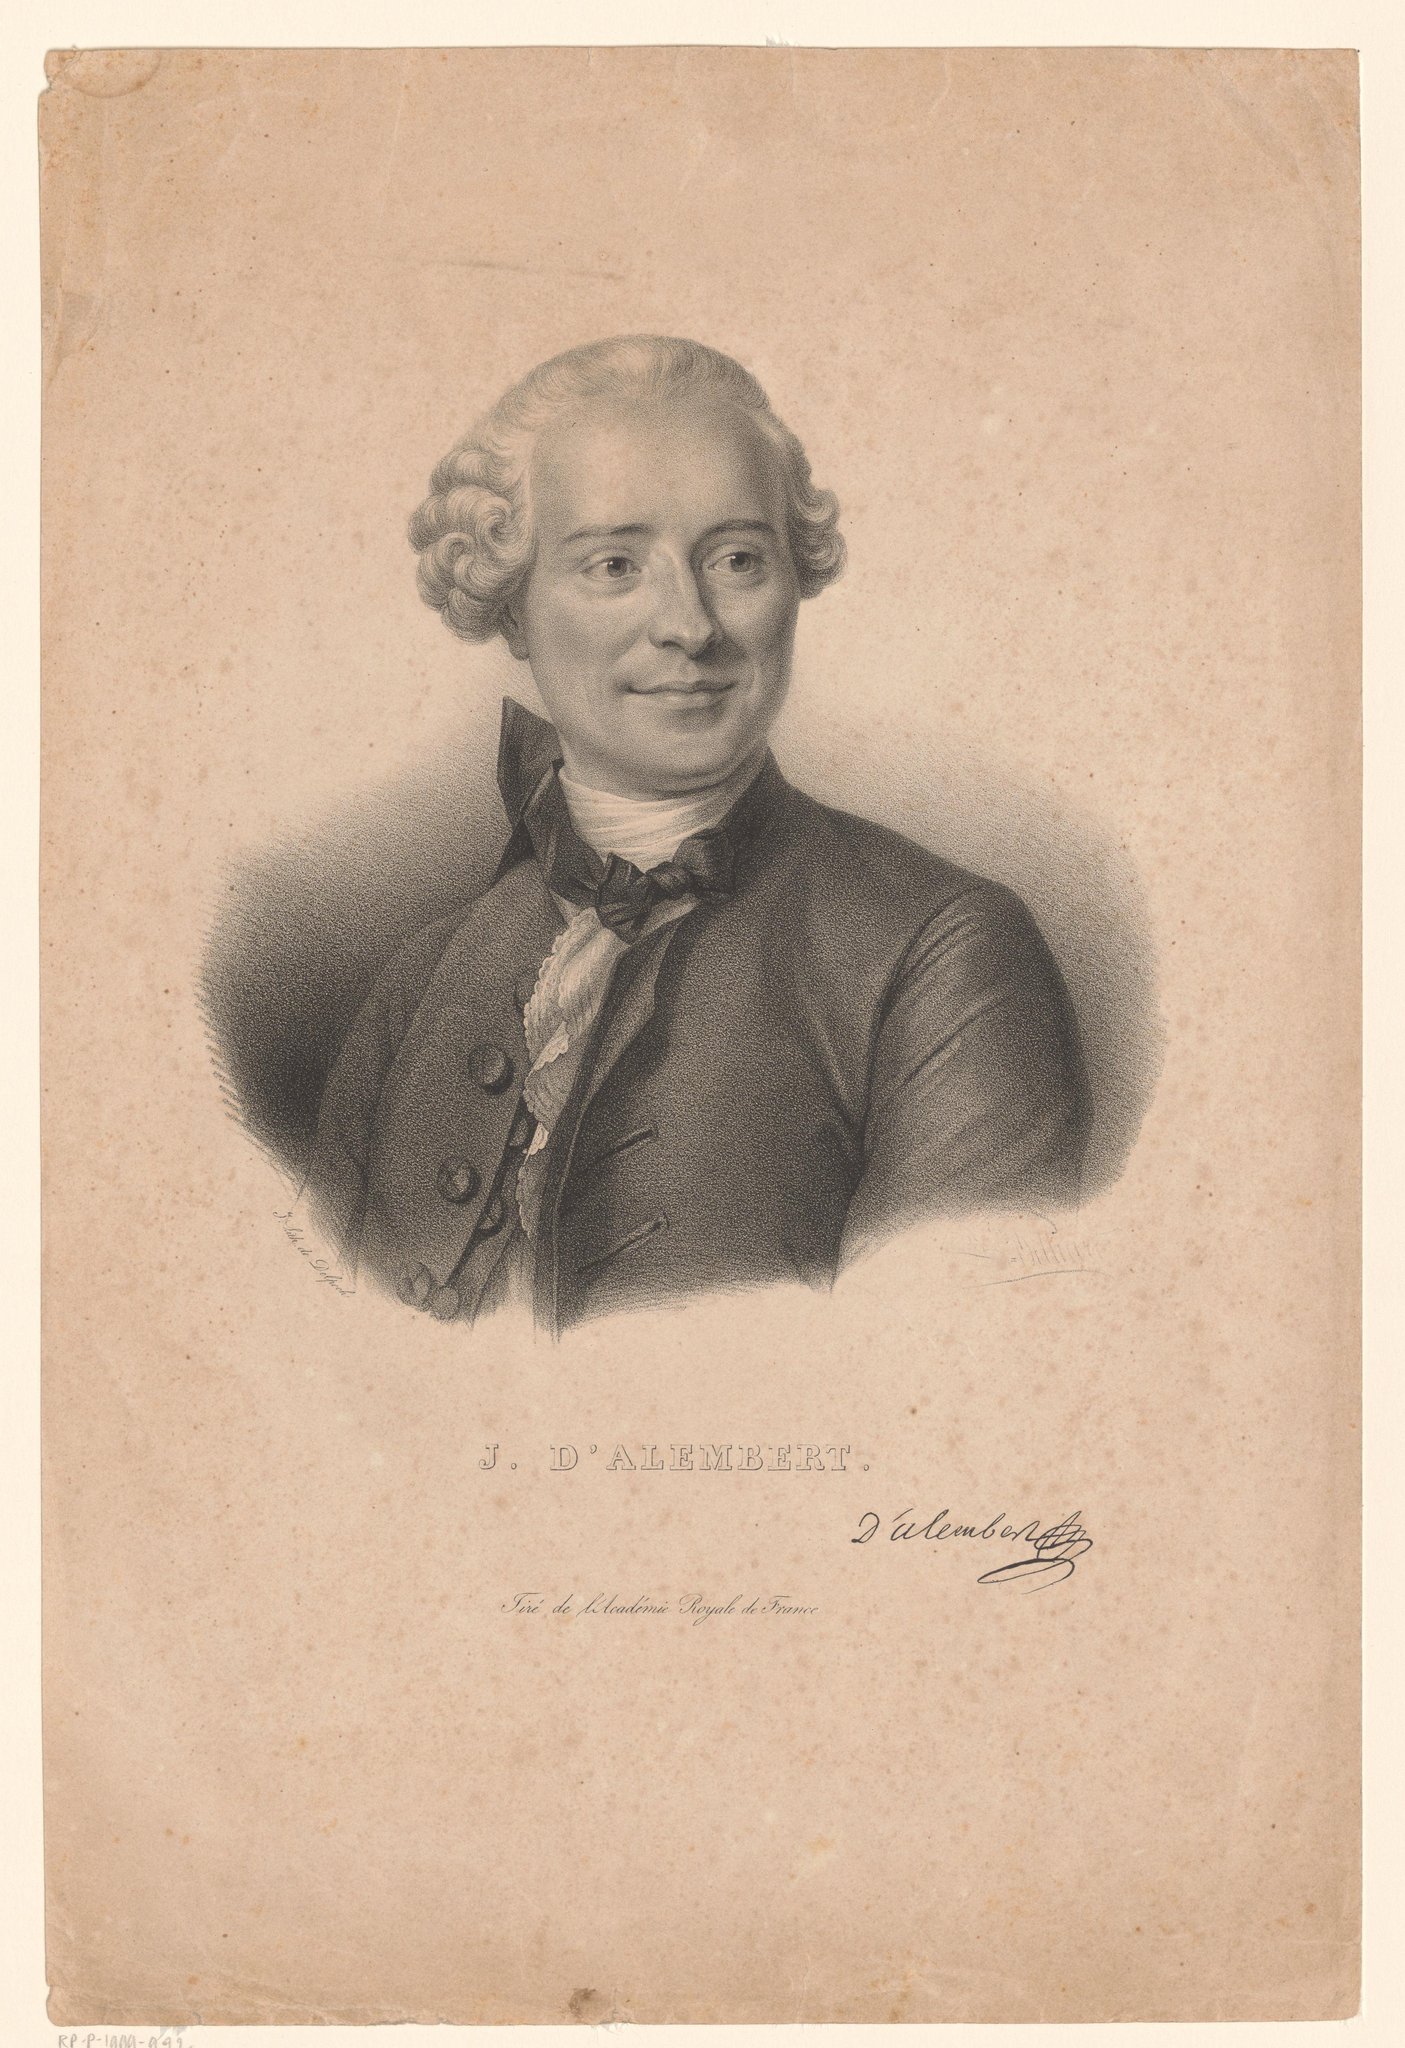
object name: print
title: Portret van Jean le Rond d'Alembert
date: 1818-1842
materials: paper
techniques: lithograph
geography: paris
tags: paris, physicist, historical persons, mathematics (+ portrait of scholar, scientist)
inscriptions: collector's mark: Lugt 2228, collector's mark: Lugt 2760